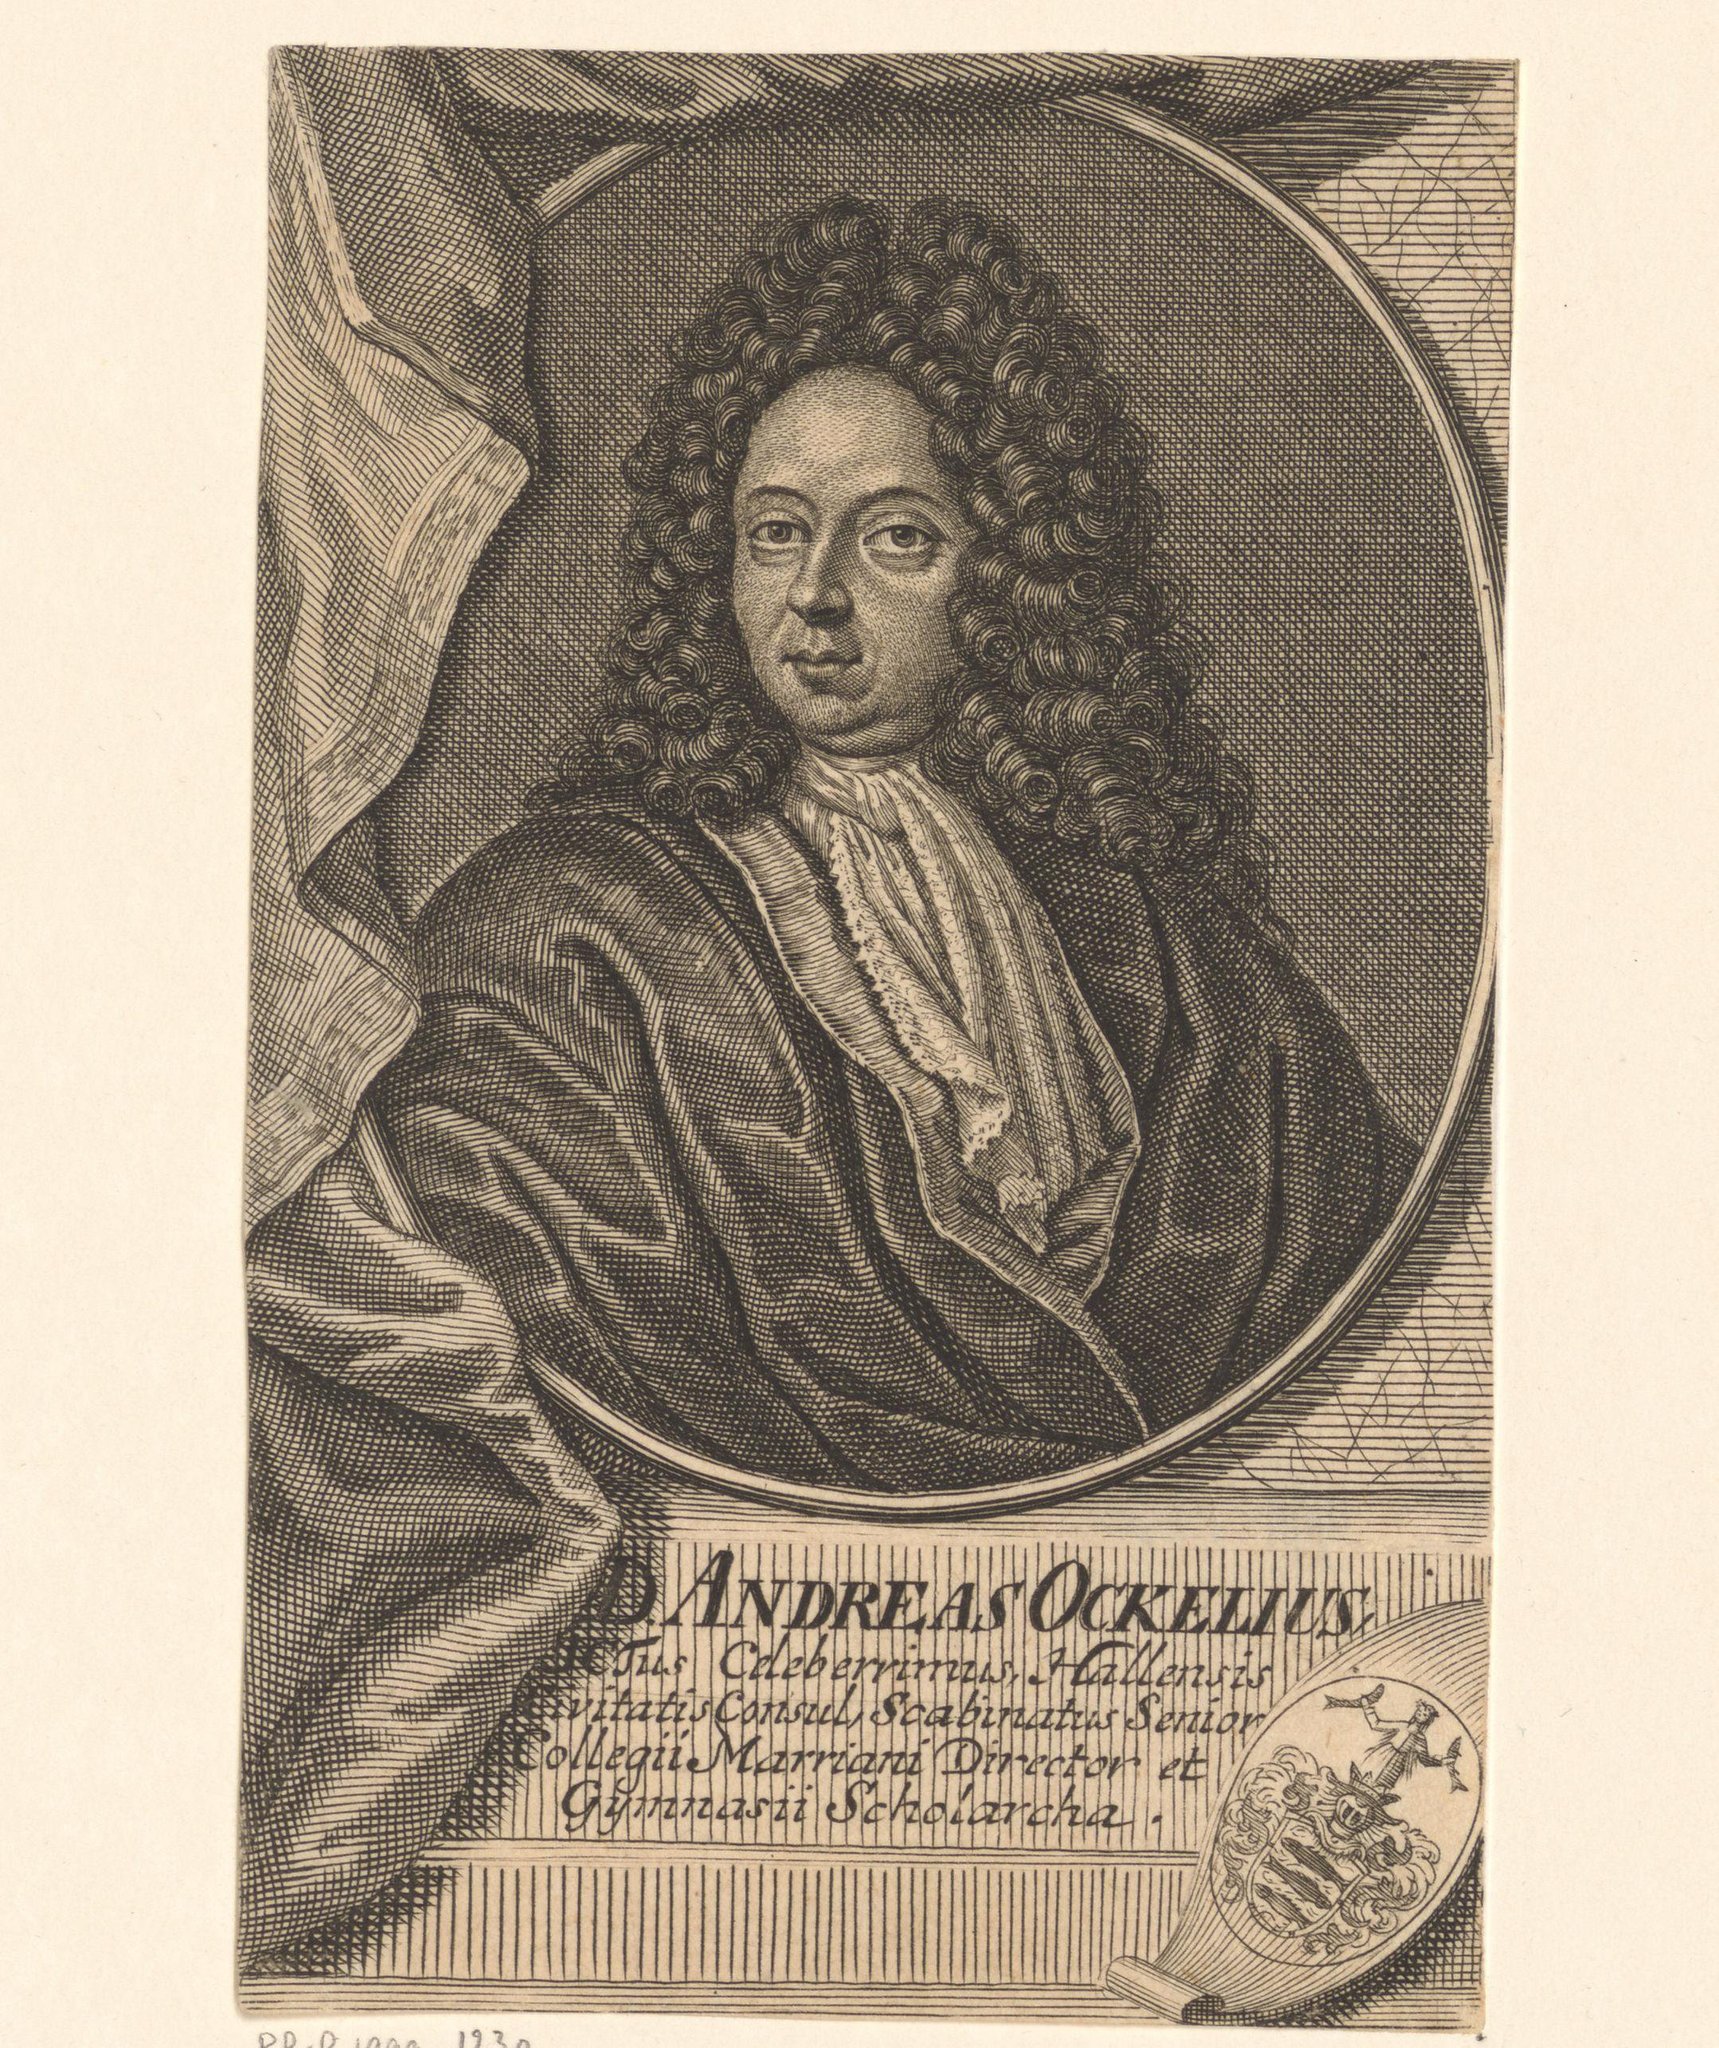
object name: print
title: Portret van Andreas Ockel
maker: johann georg mentzel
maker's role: print maker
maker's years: 1677-1743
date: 1716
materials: paper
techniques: engraving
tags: historical persons, armorial bearing, heraldry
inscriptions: collector's mark: Lugt 2760, collector's mark: Lugt 2228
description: Prent mogelijk uit: Neue Bibliothec Oder Nachricht und Urtheile von neuen Büchern Und allerhand zur Gelehrsamkeit dienenden Sachen. Frankfurt am Main en Halle: Johann Gottfried Renger, 1716.